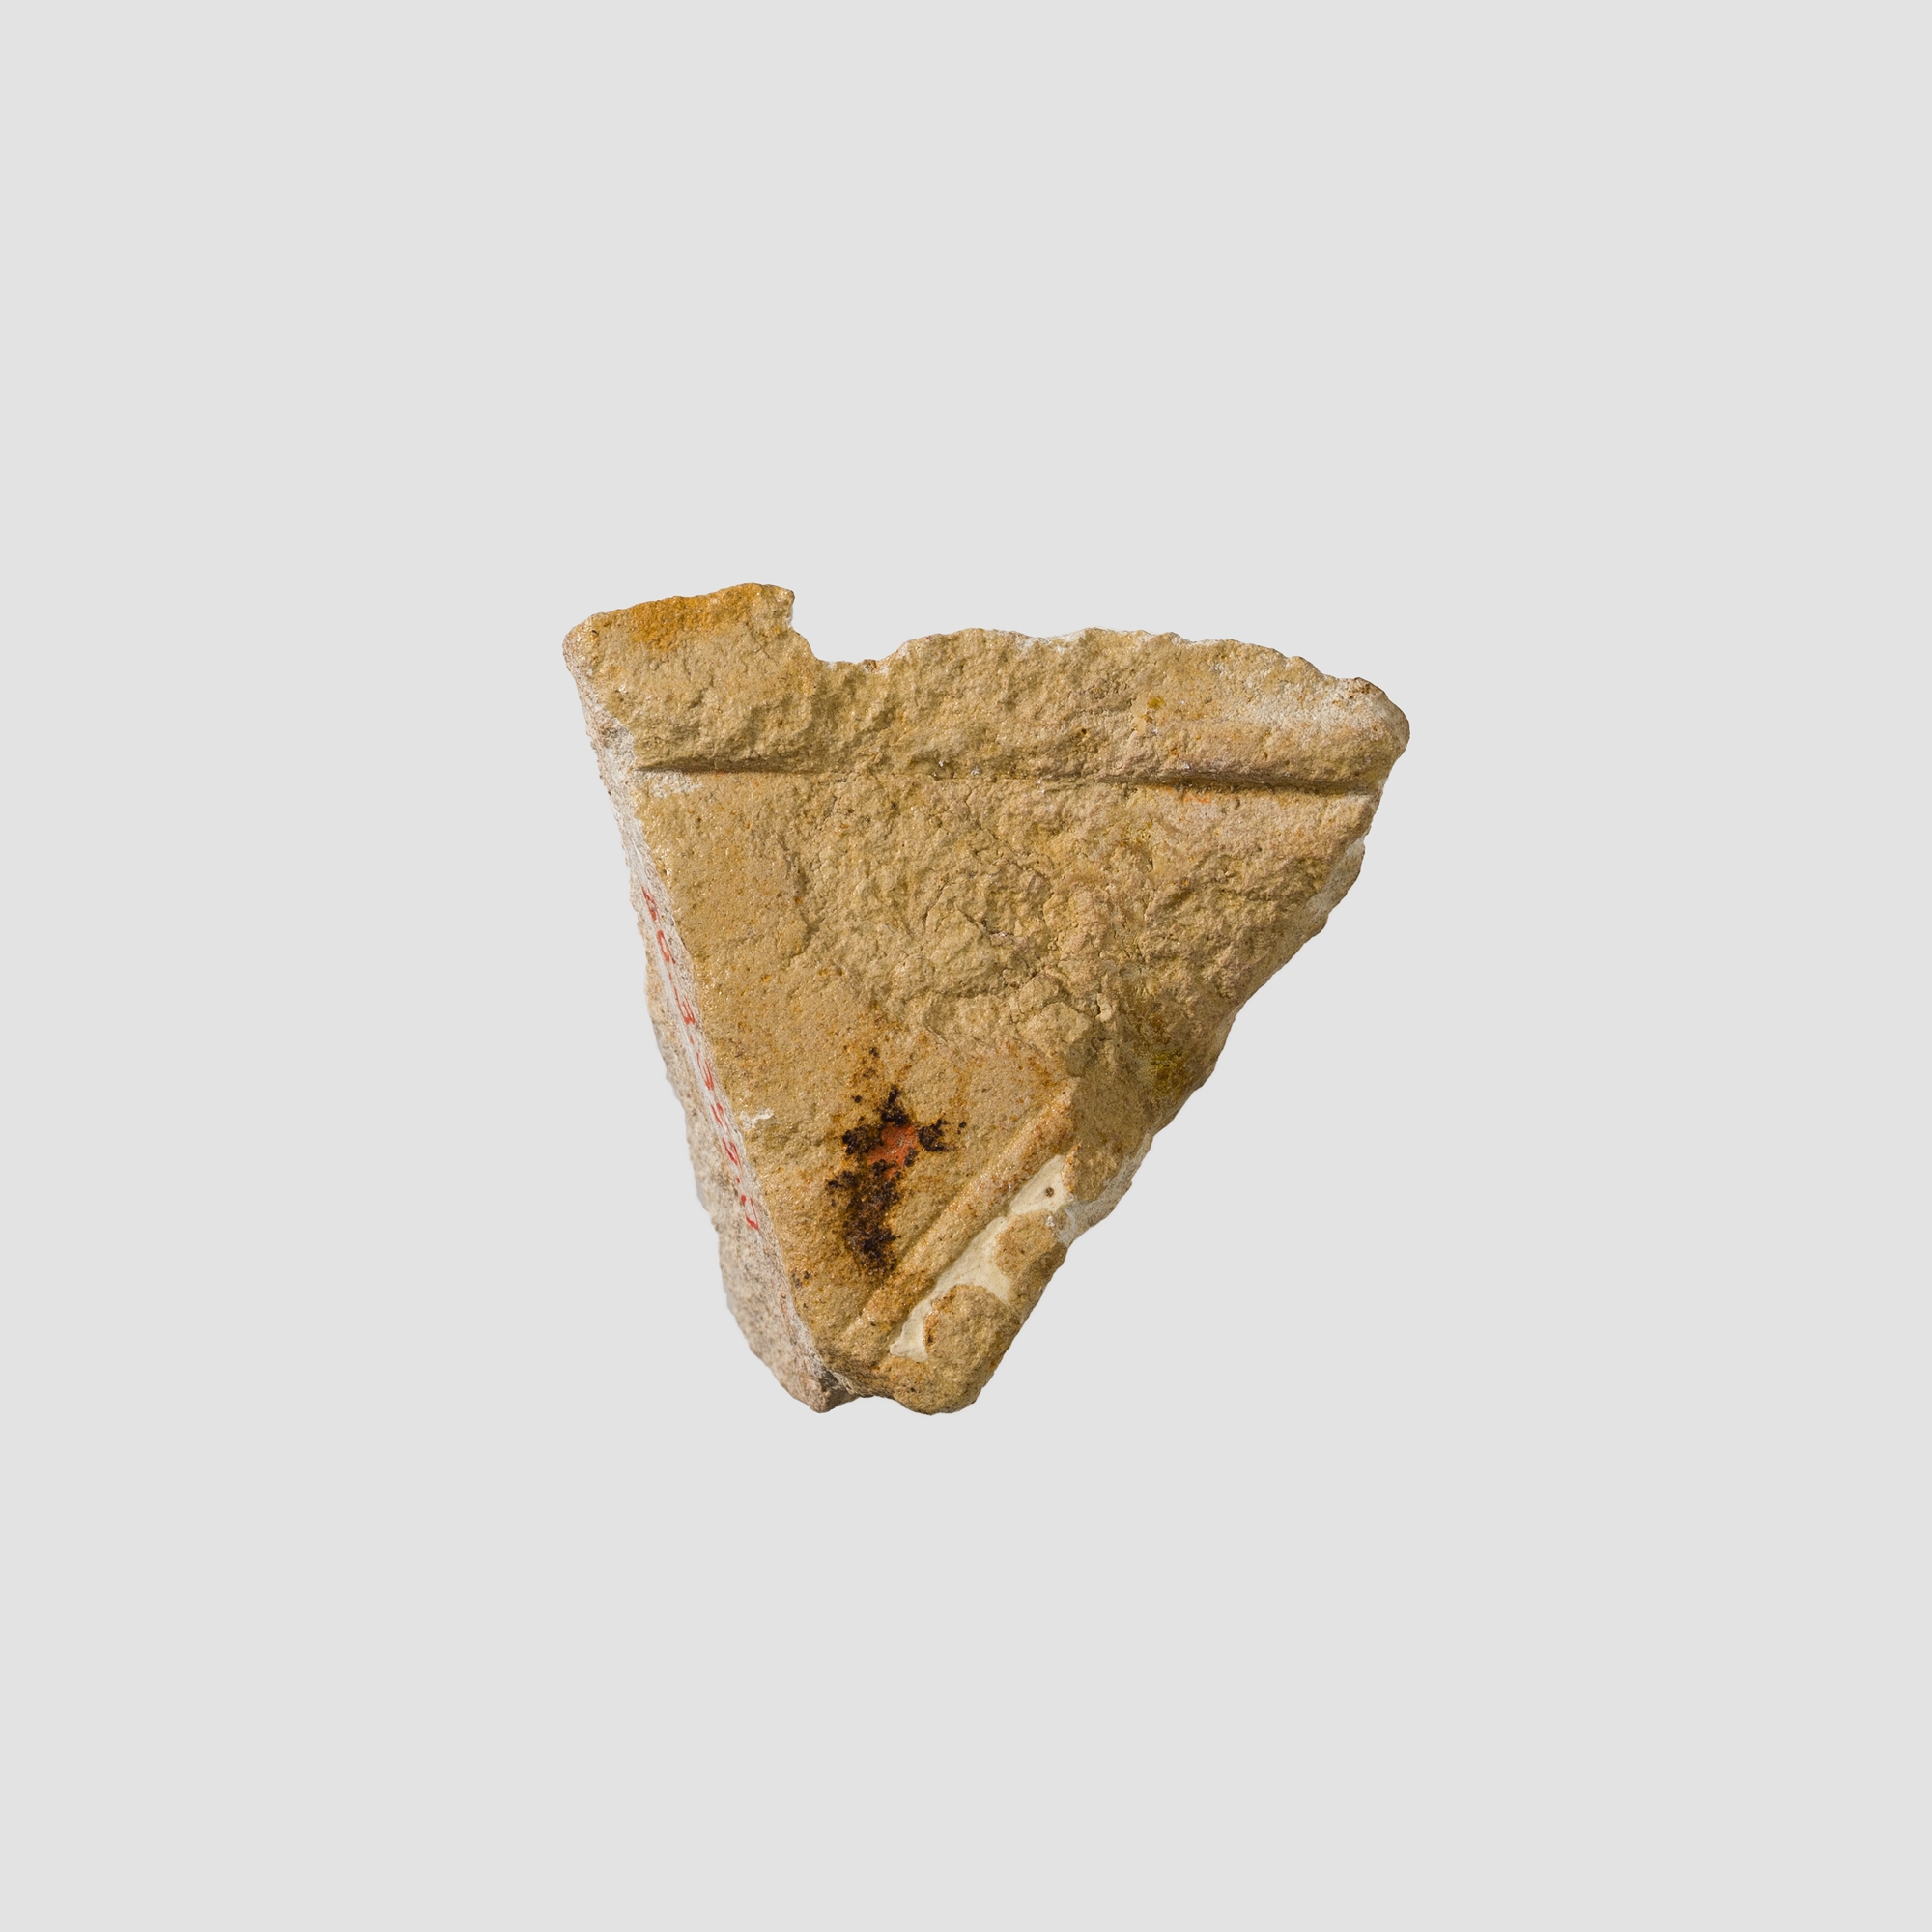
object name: relief fragment, neferu or khety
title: Relief Fragment from the Tomb of Neferu or Khety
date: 2030-1640 BCE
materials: limestone, paint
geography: egypt